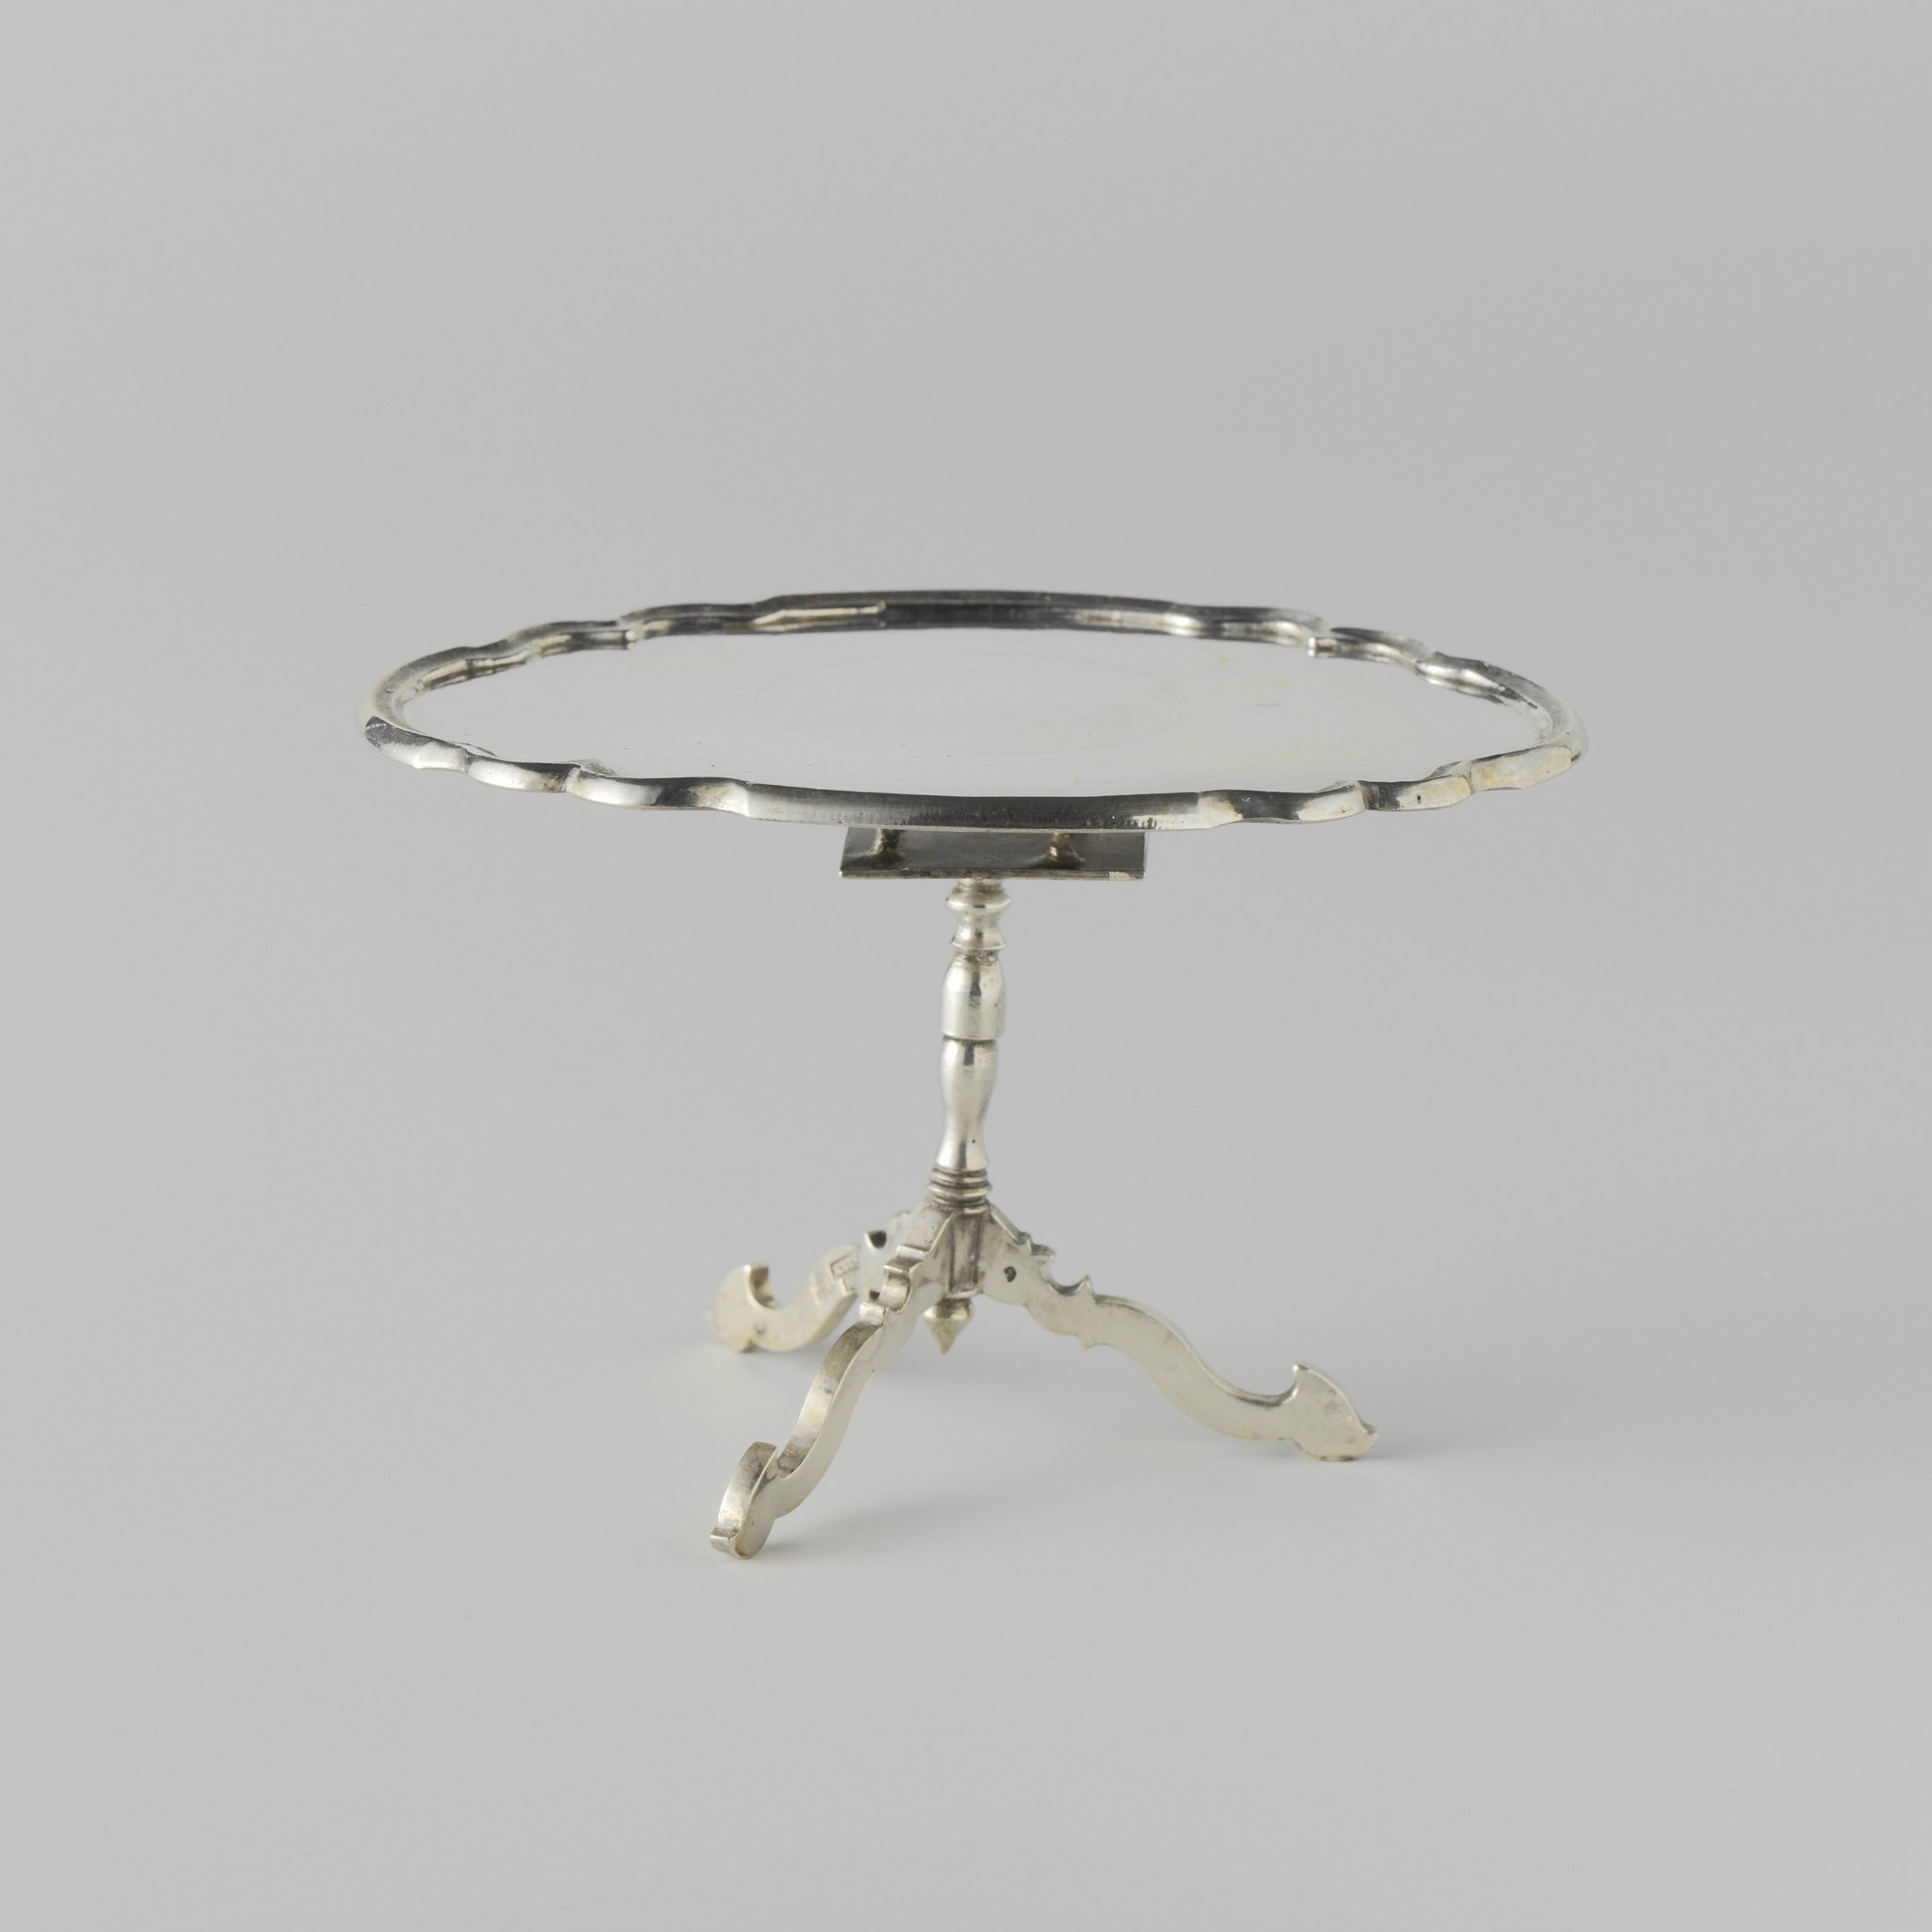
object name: miniature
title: Klaptafel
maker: arnoldus van geffen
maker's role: silversmith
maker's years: 1700-1769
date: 1759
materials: silver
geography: amsterdam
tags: tripod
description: Klaptafel op een balustervormige poot die uitloopt in een driepoot. Het blad is ovaal en heeft een geappliceerde, geschulpte rand. De klaptafel is gemerkt: stk.= Amsterdam, jrl.= Z (1759) en mt.= Arnoldus van Geffen. Op de tafel wordt een dienblad met een koffie- en theeservies bewaard (BK-NM-11177-158). De klaptafel is gelijk aan een klaptafel met invnr. BK-NM-11177-181-a.